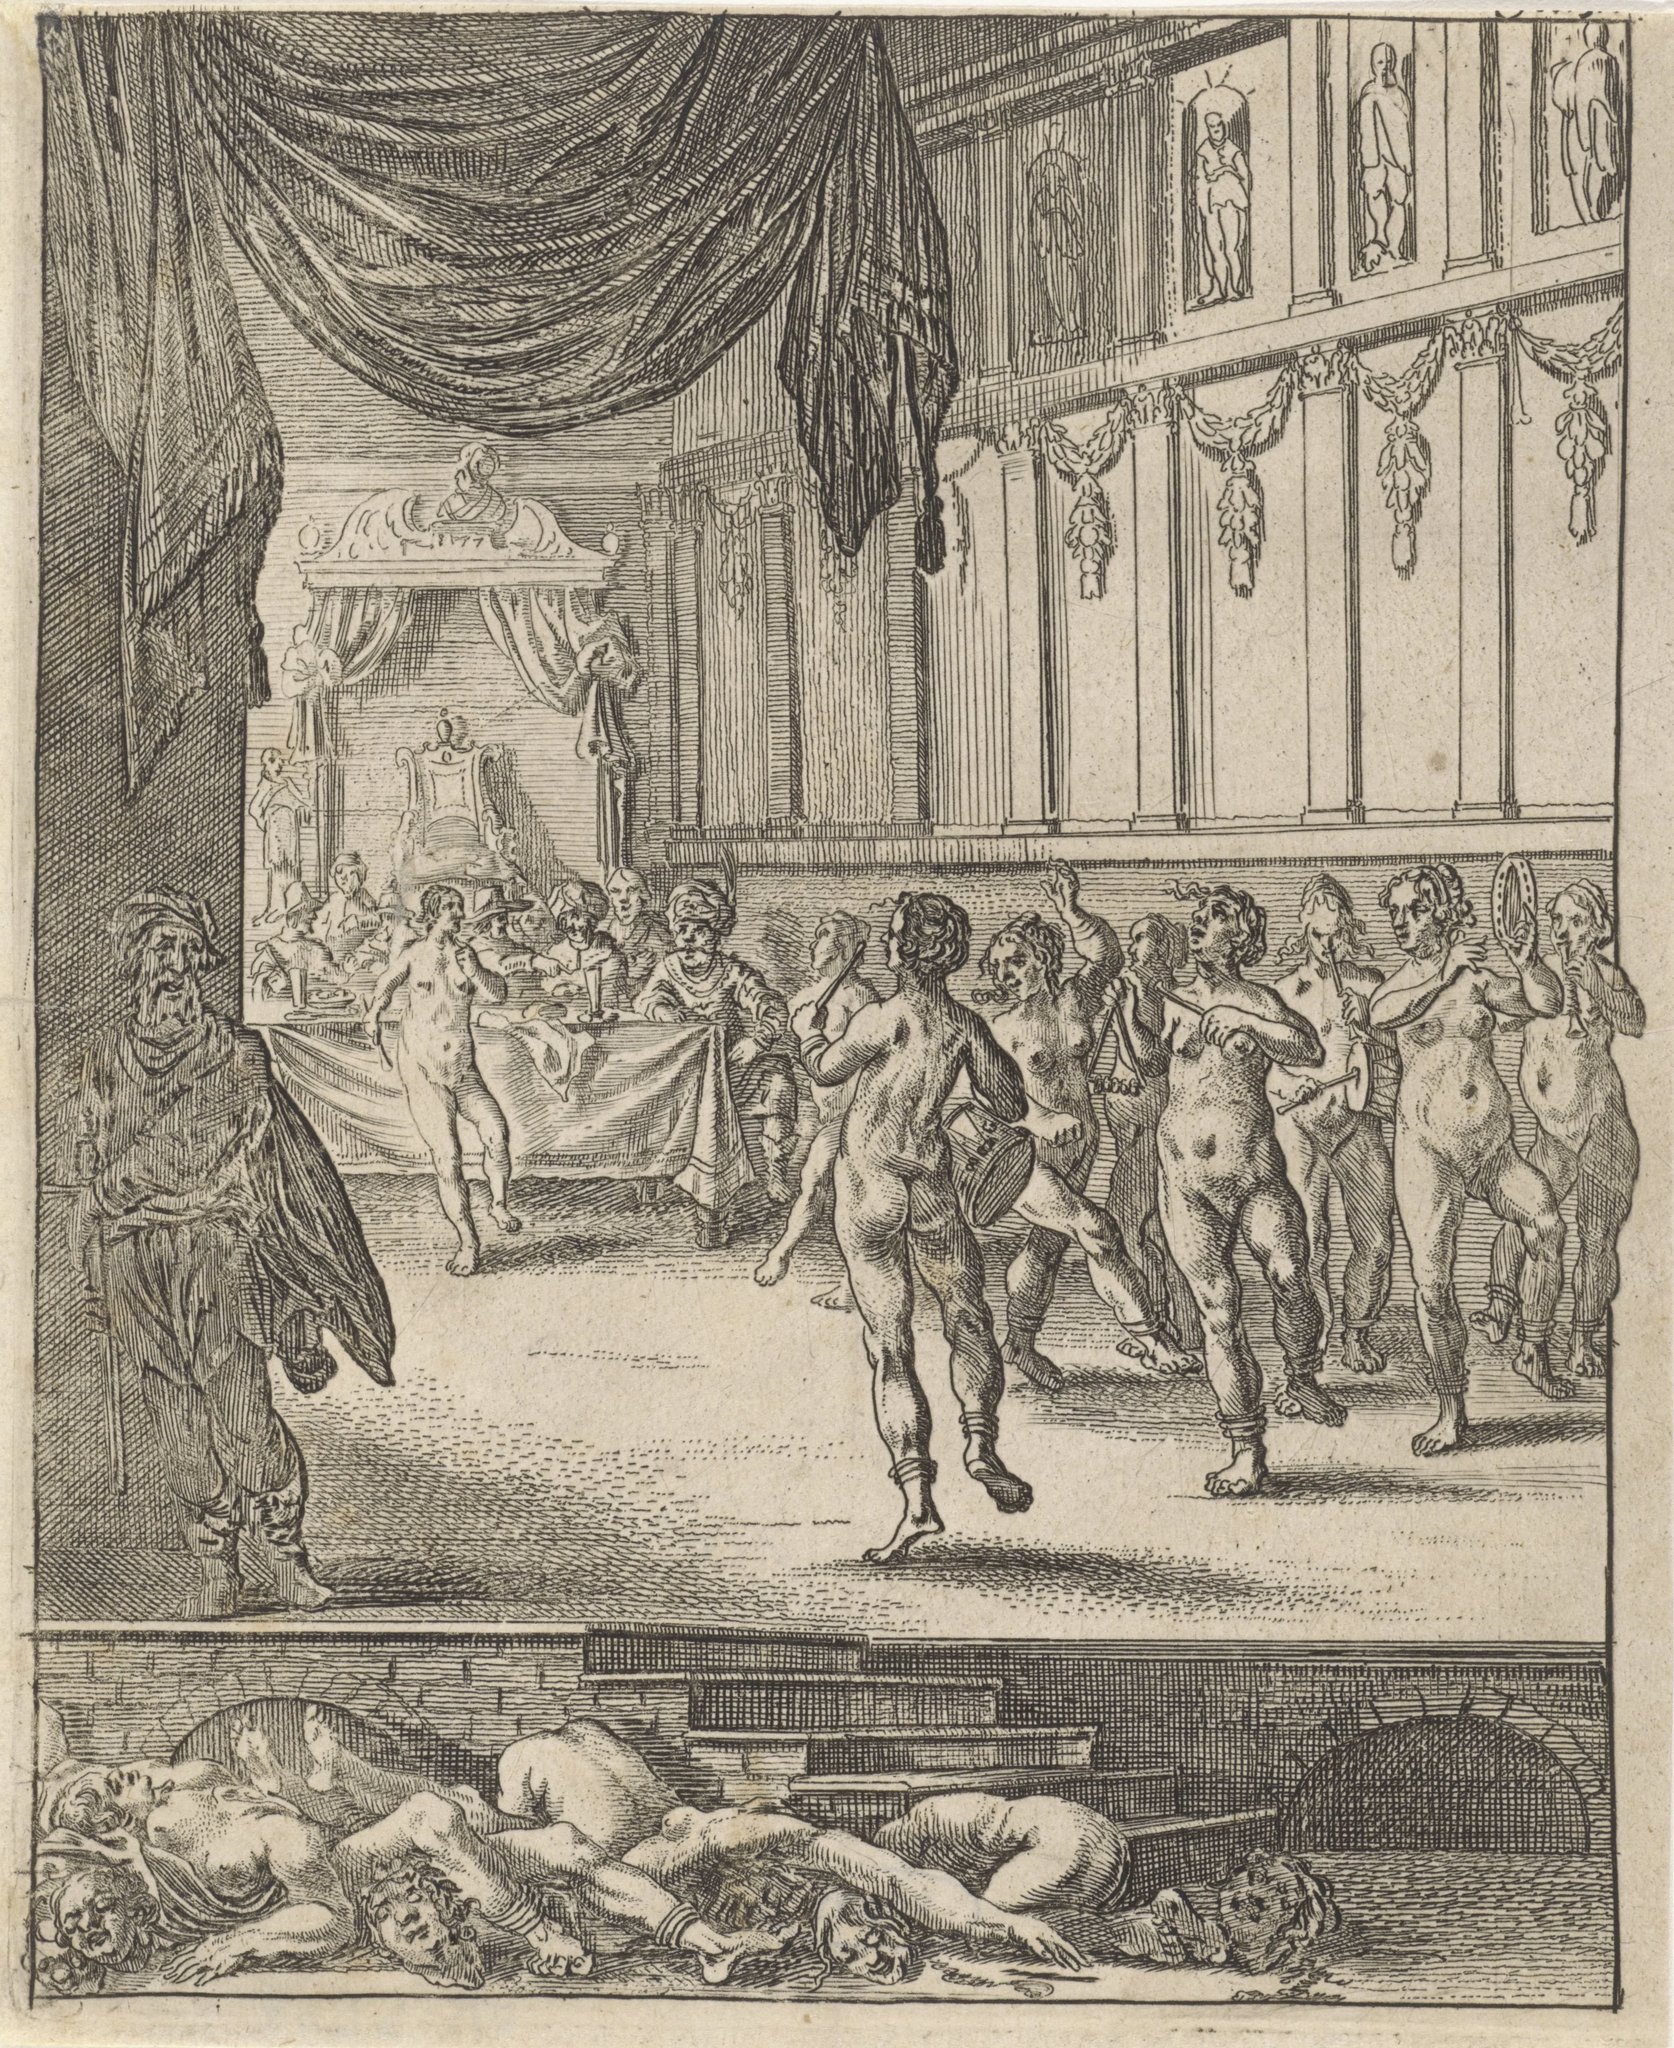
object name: print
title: Naakte dansende en muziekmakende slavinnen voordat zij ter dood worden gebracht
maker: salomon savery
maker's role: print maker, publisher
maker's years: 1594-1683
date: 1610-1665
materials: paper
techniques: engraving, etching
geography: amsterdam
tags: last hours before execution, dancing, woman (showing herself) undressed, quasi-nude, slavery; serfs and enslaved persons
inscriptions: collector's mark: Lugt 2228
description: Mogelijk aan een Ottomaans hof. Op de achtergrond zitten mannen met tulbanden en mannen in Europese kledij aan tafel toe te kijken. Linksvoor de beul met daaronder de onthoofde lichamen van de vrouwen.